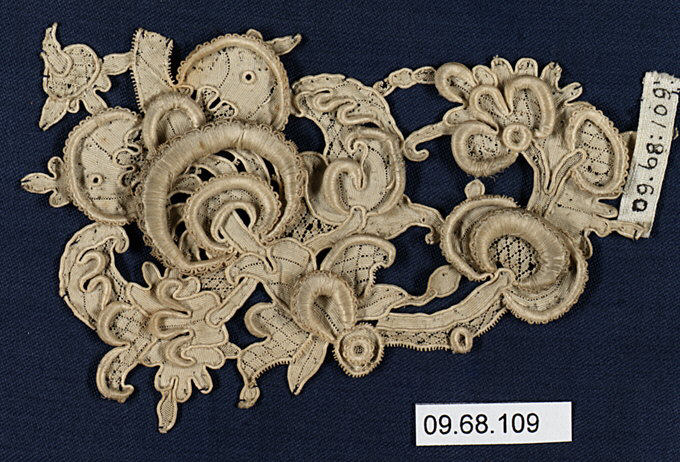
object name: fragment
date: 1601-1700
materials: lace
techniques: gros point, lace